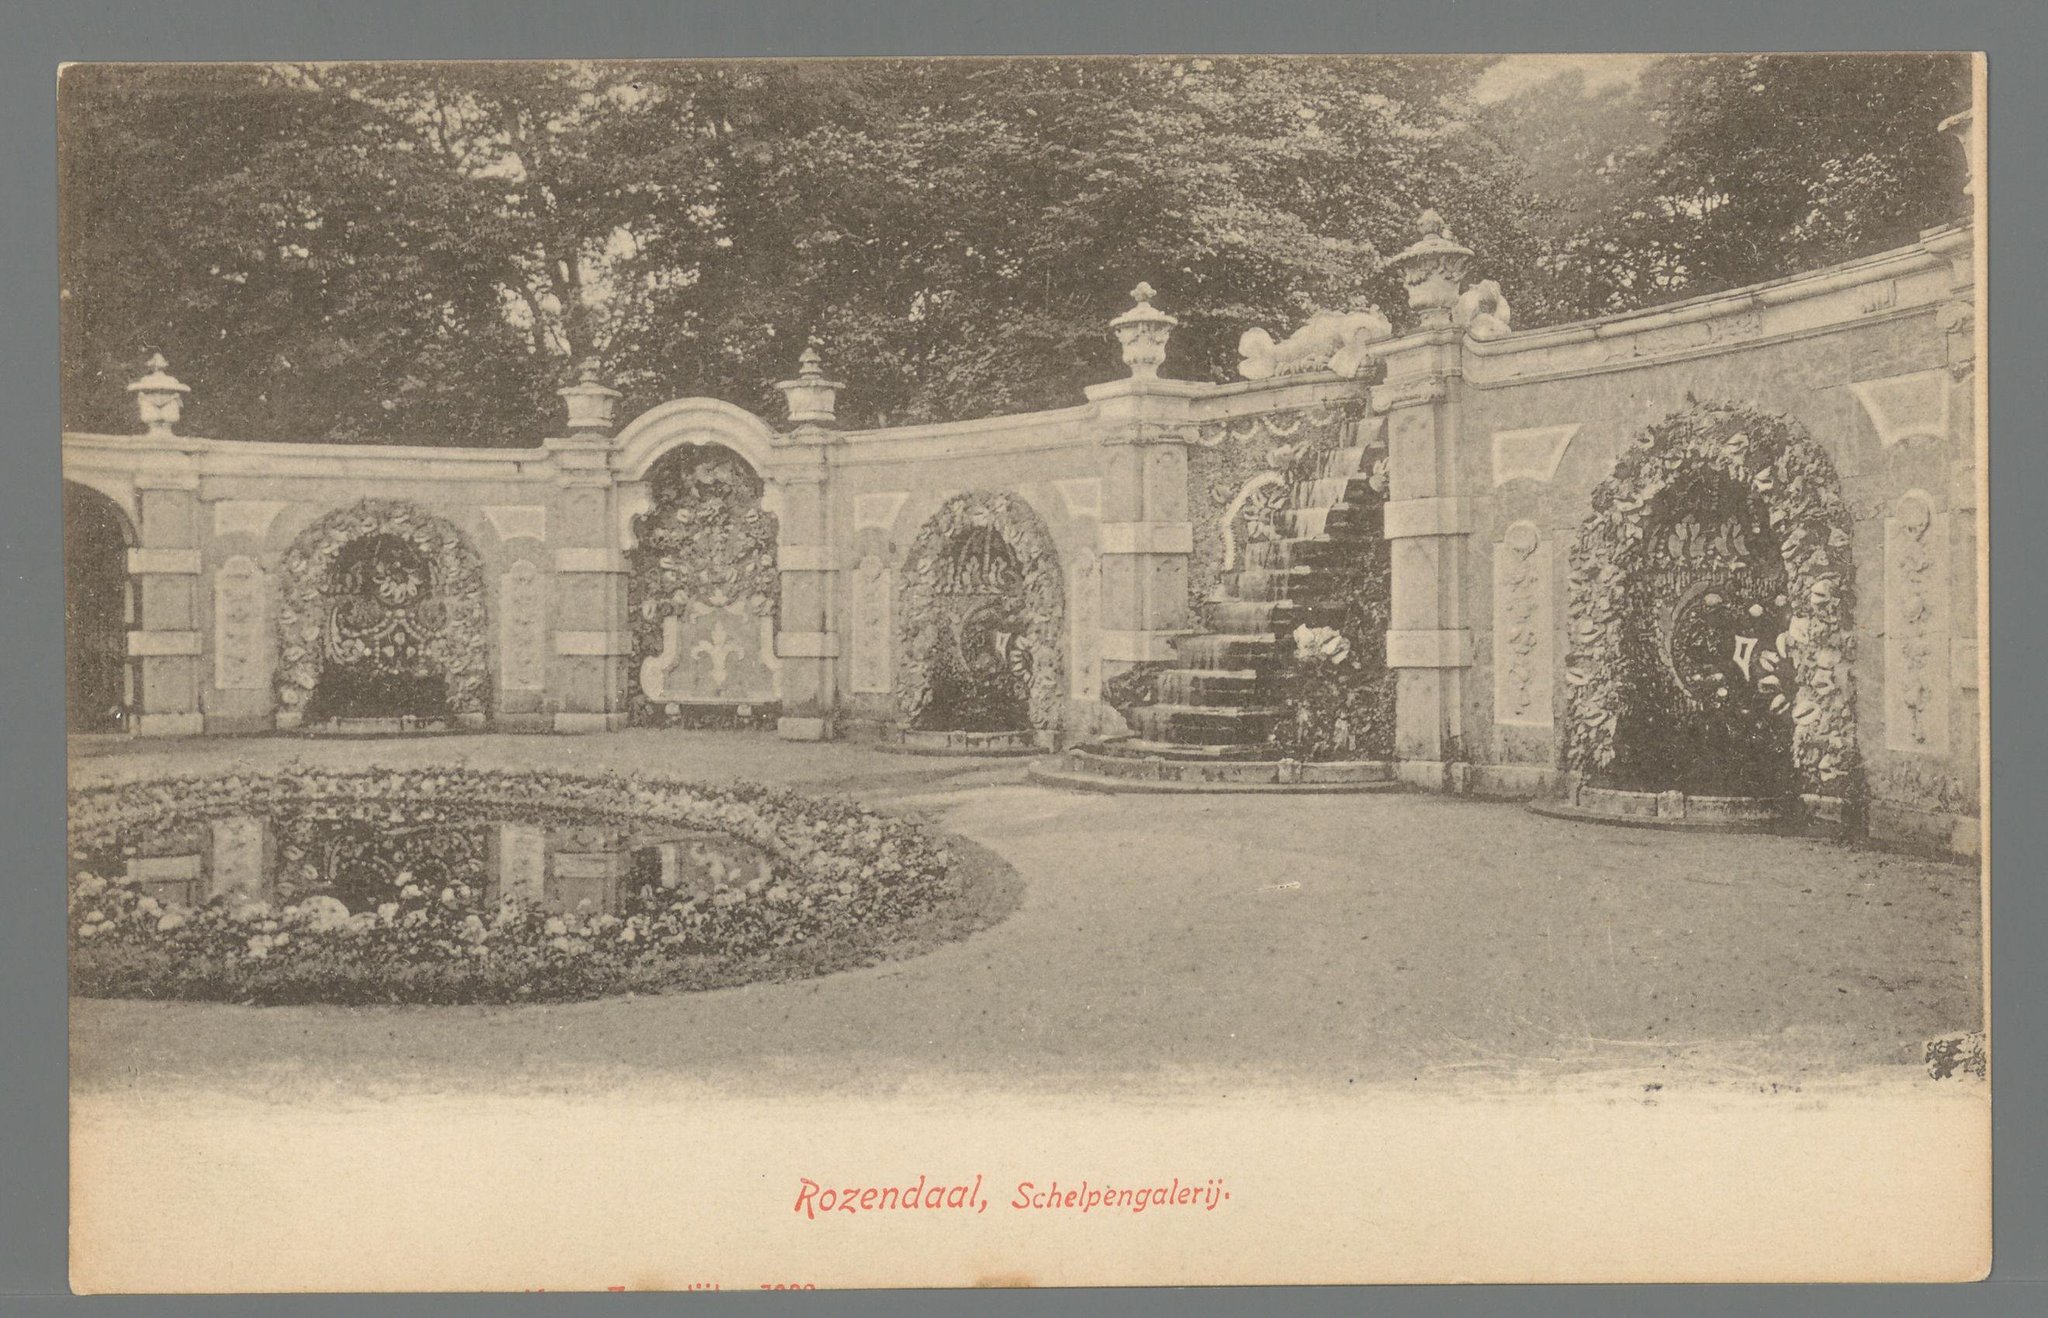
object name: photomechanical print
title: Rozendaal, Schelpengalerij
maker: Anonymous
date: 1897-1905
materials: cardboard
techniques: photograph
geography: rozendaal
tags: scallop, shell ~ ornament